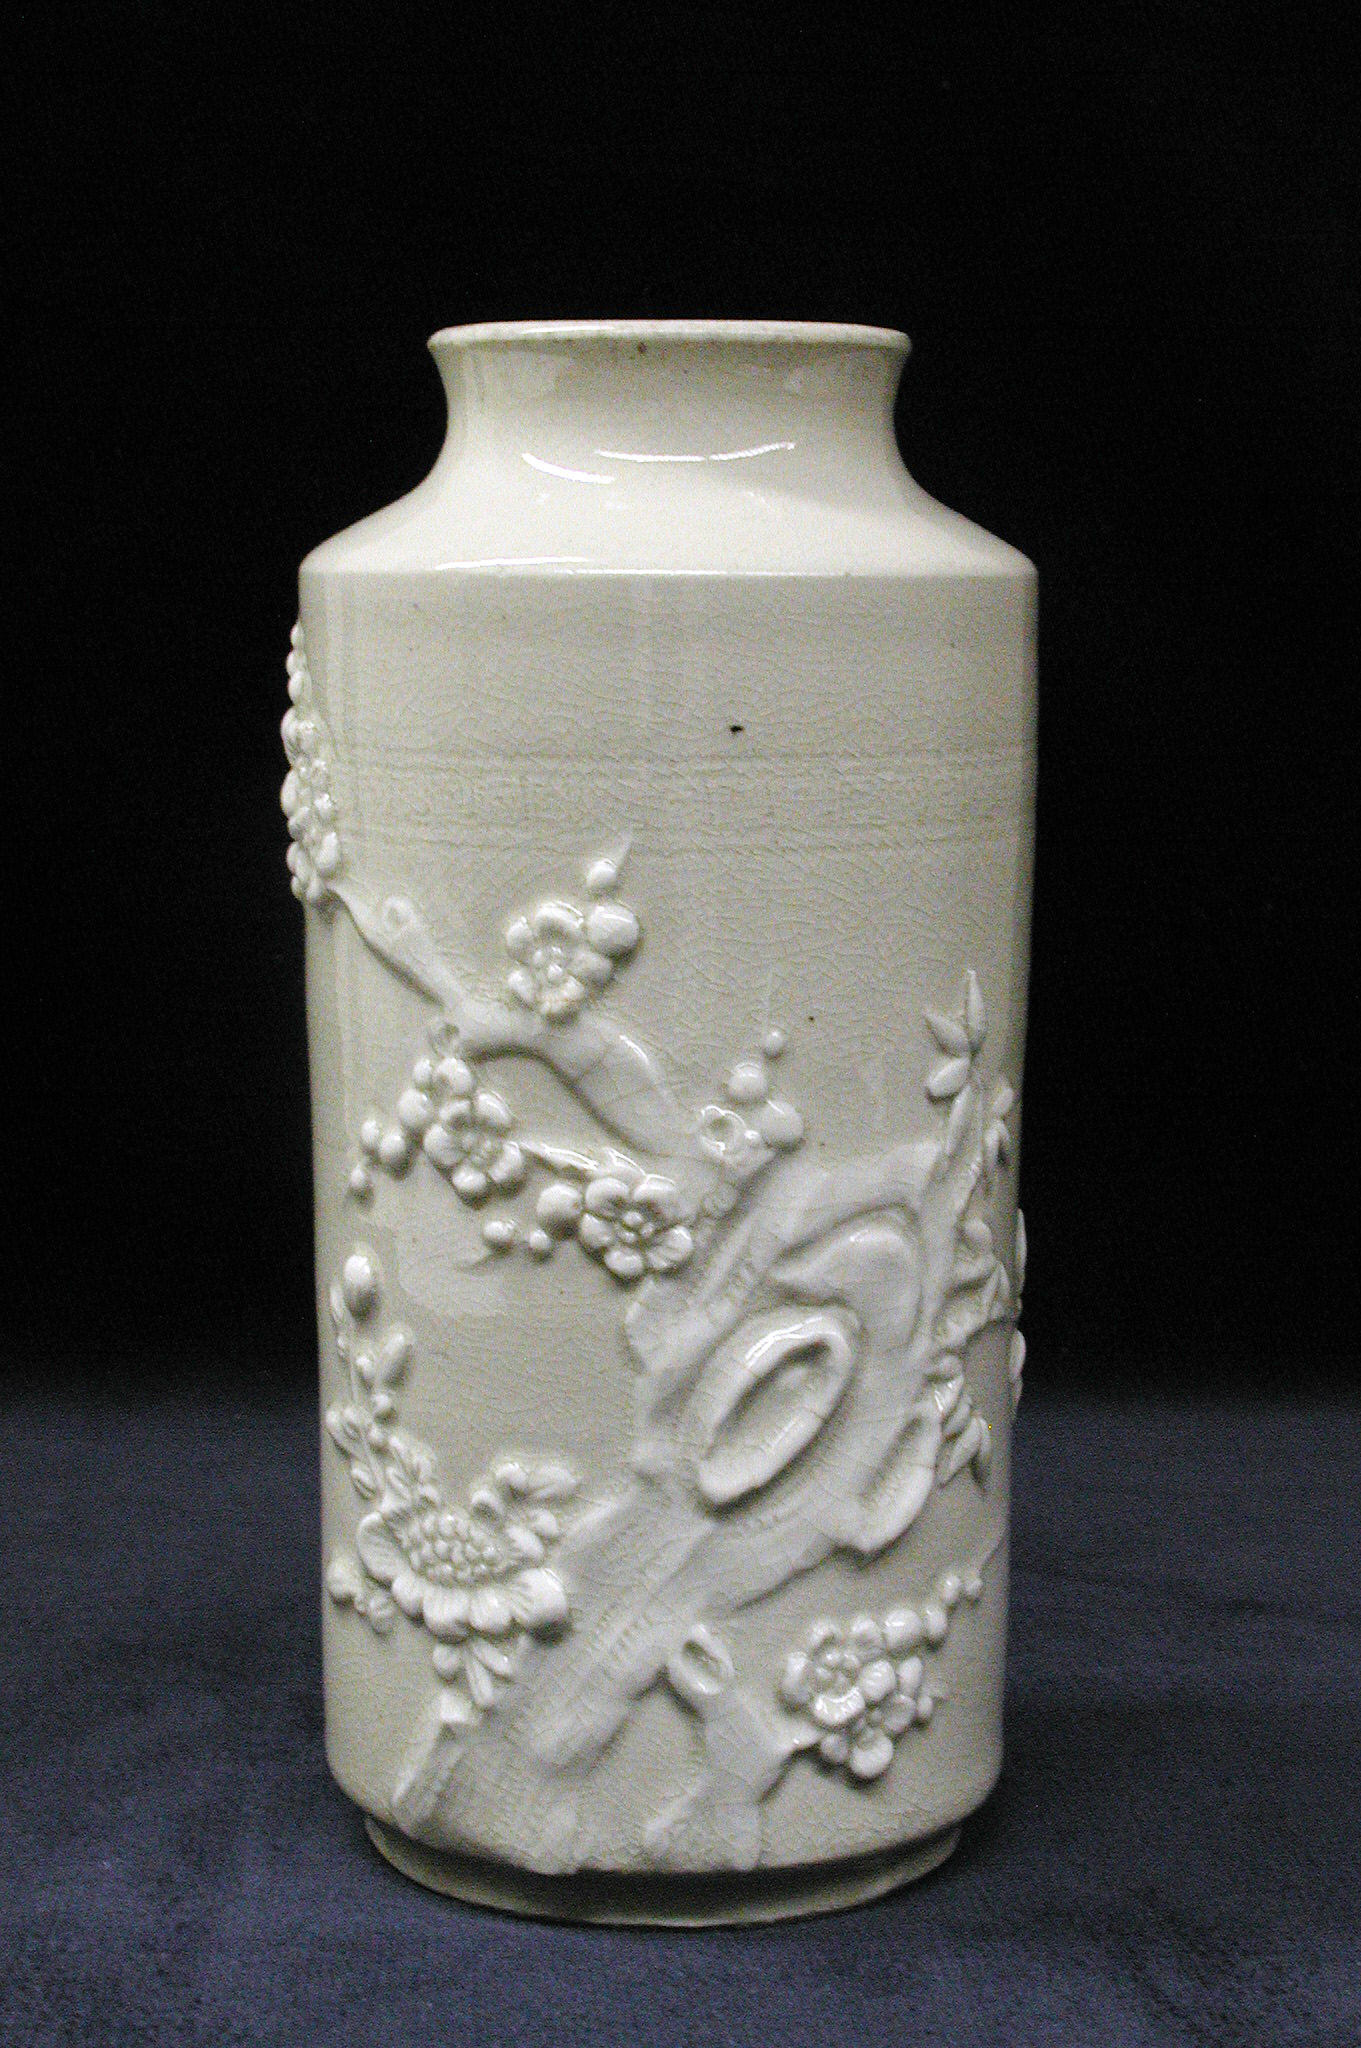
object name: vase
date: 1701-1800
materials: hard paste porcelain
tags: flowers